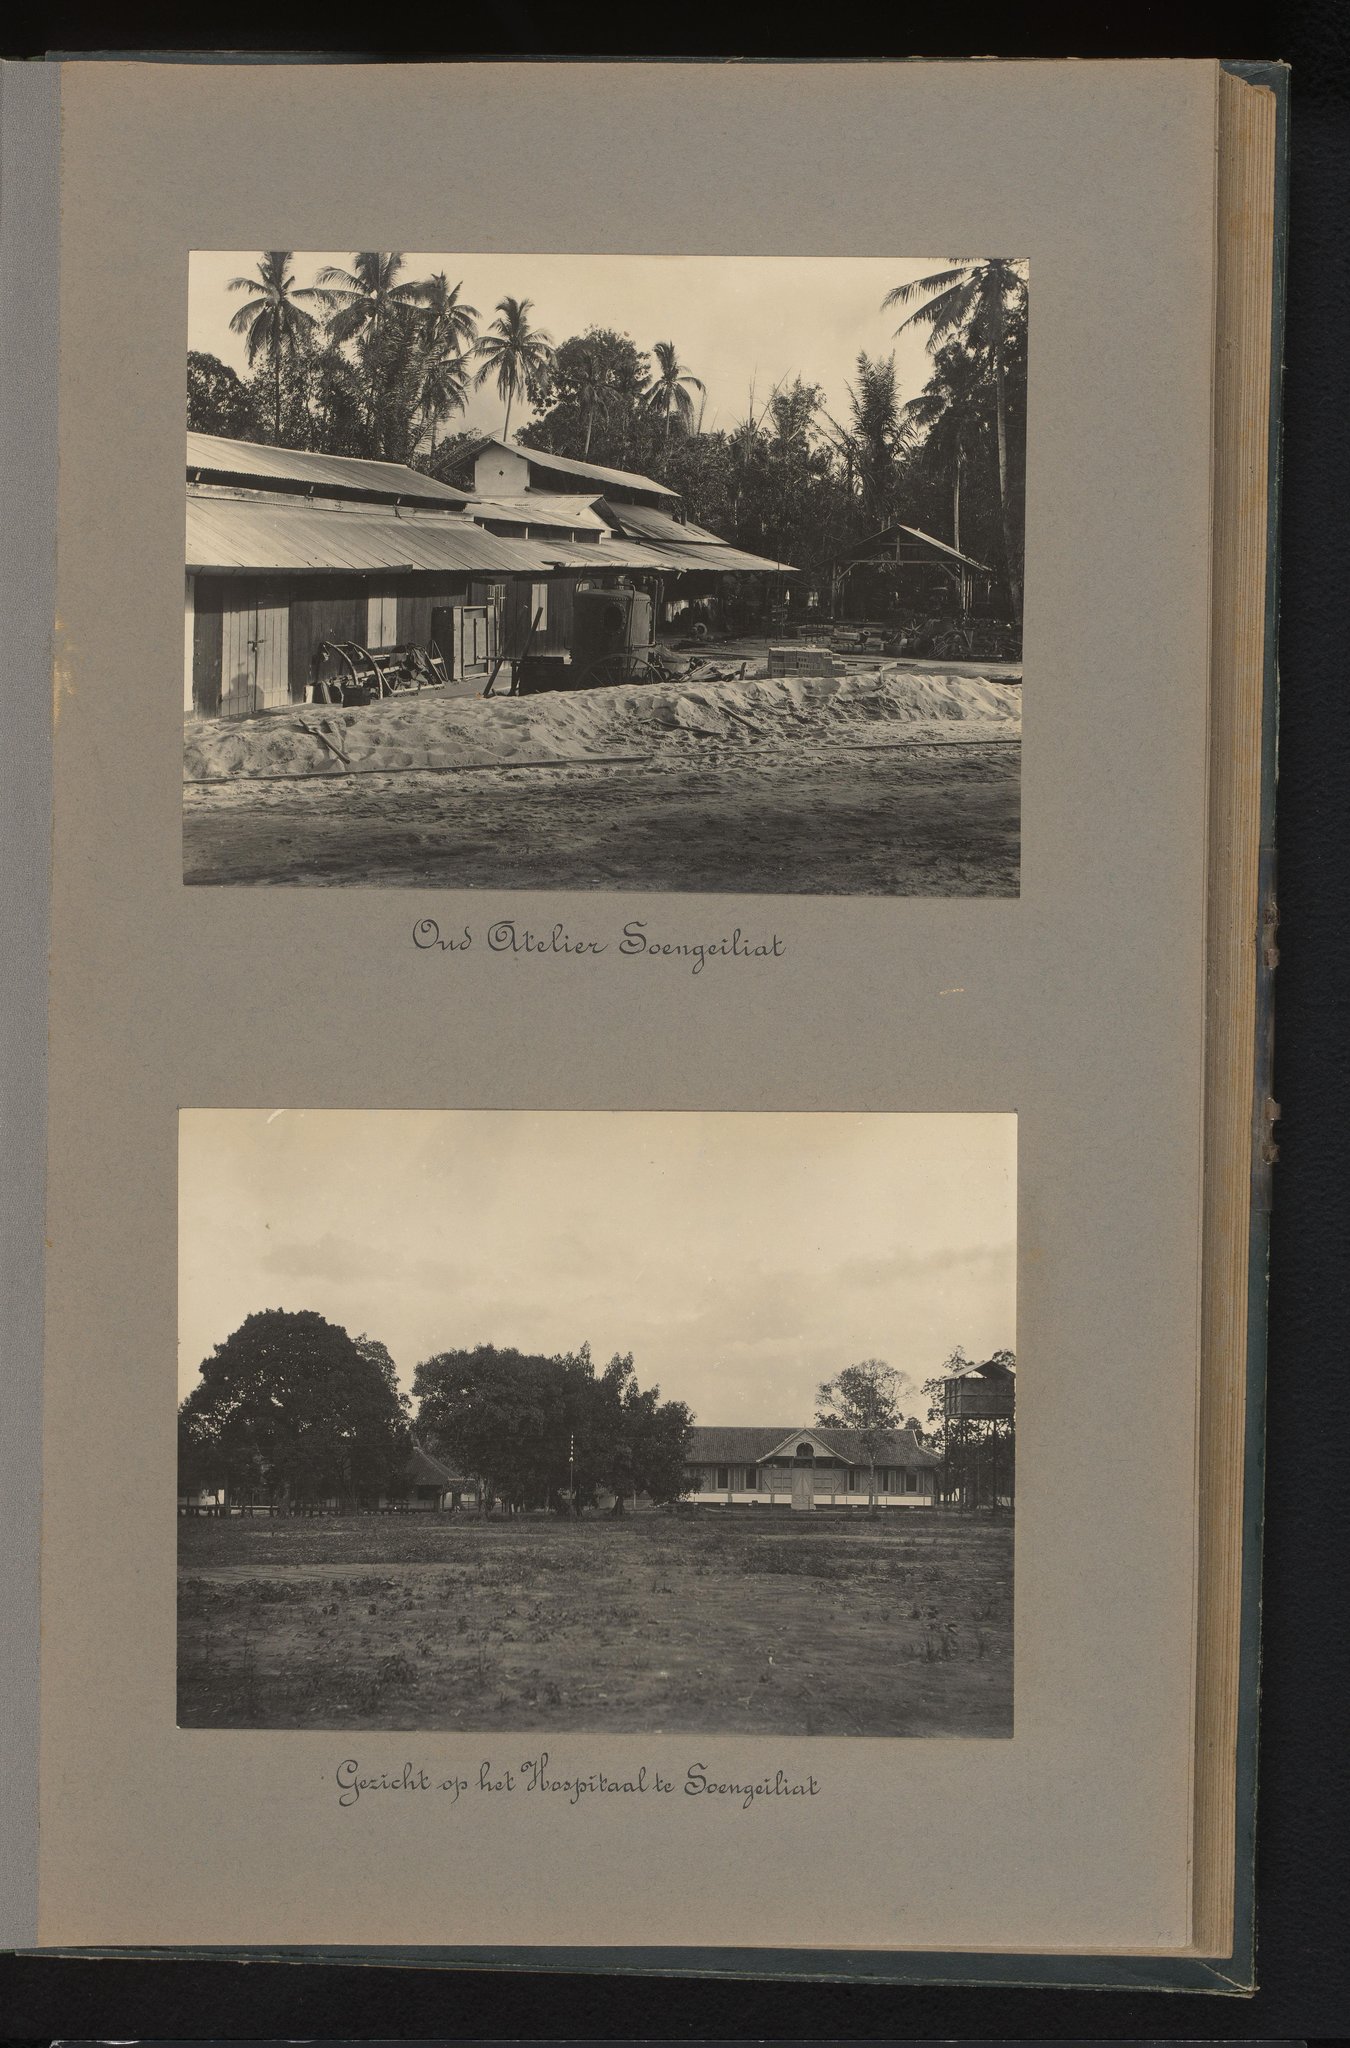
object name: album leaf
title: Atelier en hospitaal van de Banka-tinwinning te Soengeiliat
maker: Anonymous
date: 1914-1919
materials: cardboard, photographic support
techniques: gelatin silver print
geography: bangka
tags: robert julius boers, colonial system, mining, hospital, exterior of industrial structures, factories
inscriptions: inscription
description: Albumblad met 2 foto's van het oude atelier en het hospitaal van de Banka-tinwinning te Soengeiliat. Onderdeel van het fotoalbum aangeboden aan Robert Julius Boers bij zijn vertrek naar Nederland in 1919 door het personeel van de Banka-tinwinning.